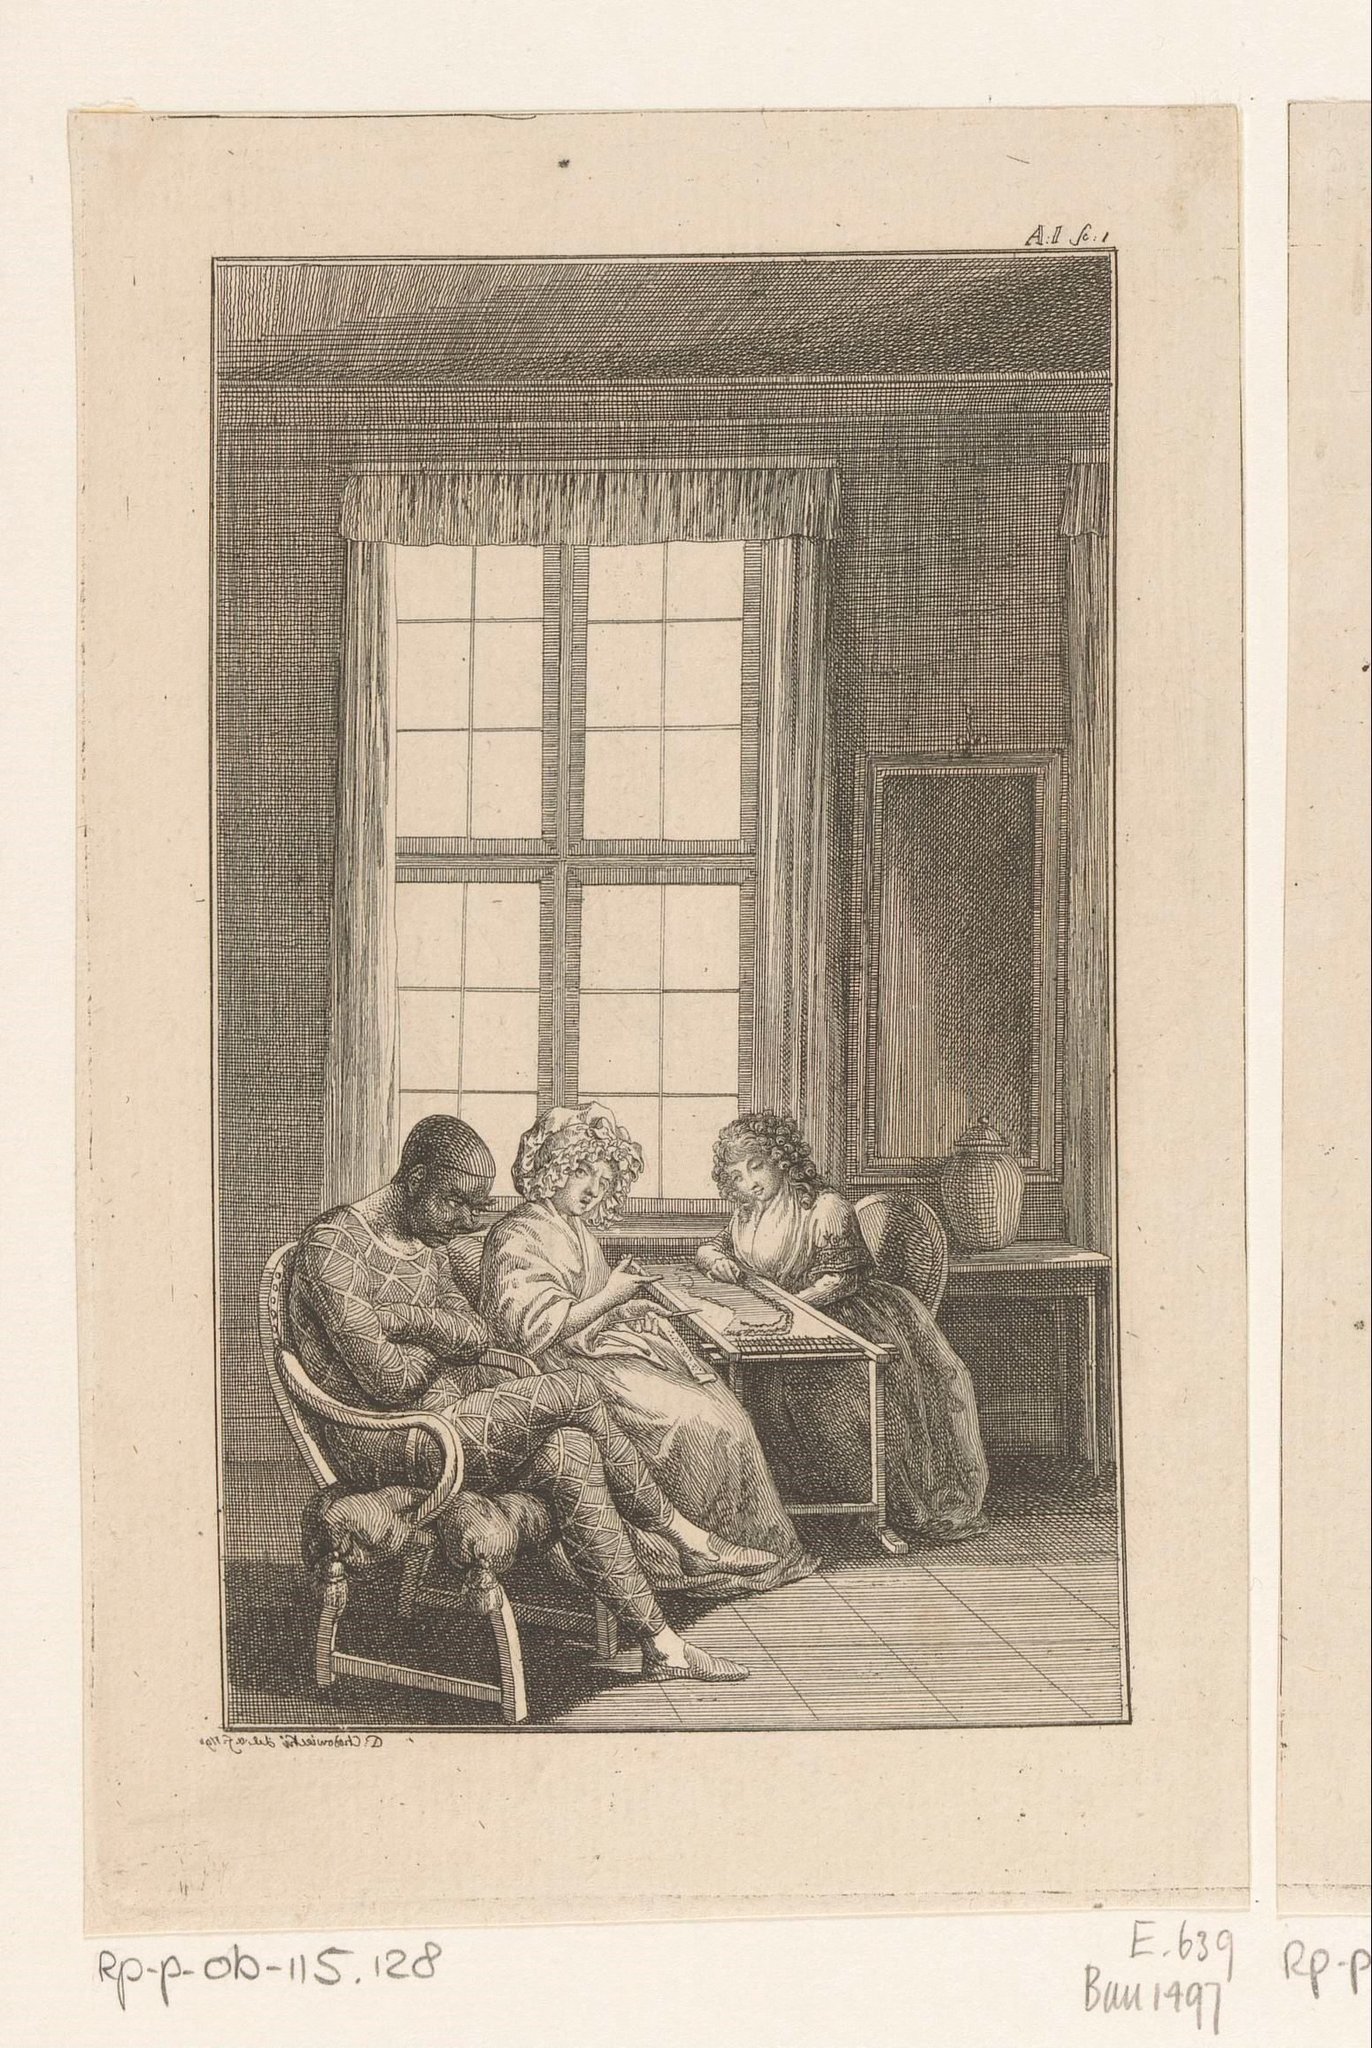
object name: print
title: Harlekijn met overgeslagen armen naast zijn vrouw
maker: daniel nikolaus chodowiecki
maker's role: draughtsman, print maker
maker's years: 1726-1801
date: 1790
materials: paper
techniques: etching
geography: berlin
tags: copenhagen (city), literature, types in 'commedia dell'arte': harlequin, arms crossed over the breast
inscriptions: collector's mark: Lugt 2228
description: Prenten gebruikt voor: Ewald, Johannes. Joh. Ewald's samtlige Skrifter. 4 dln. Kopenhagen: s.n., 1781-91.